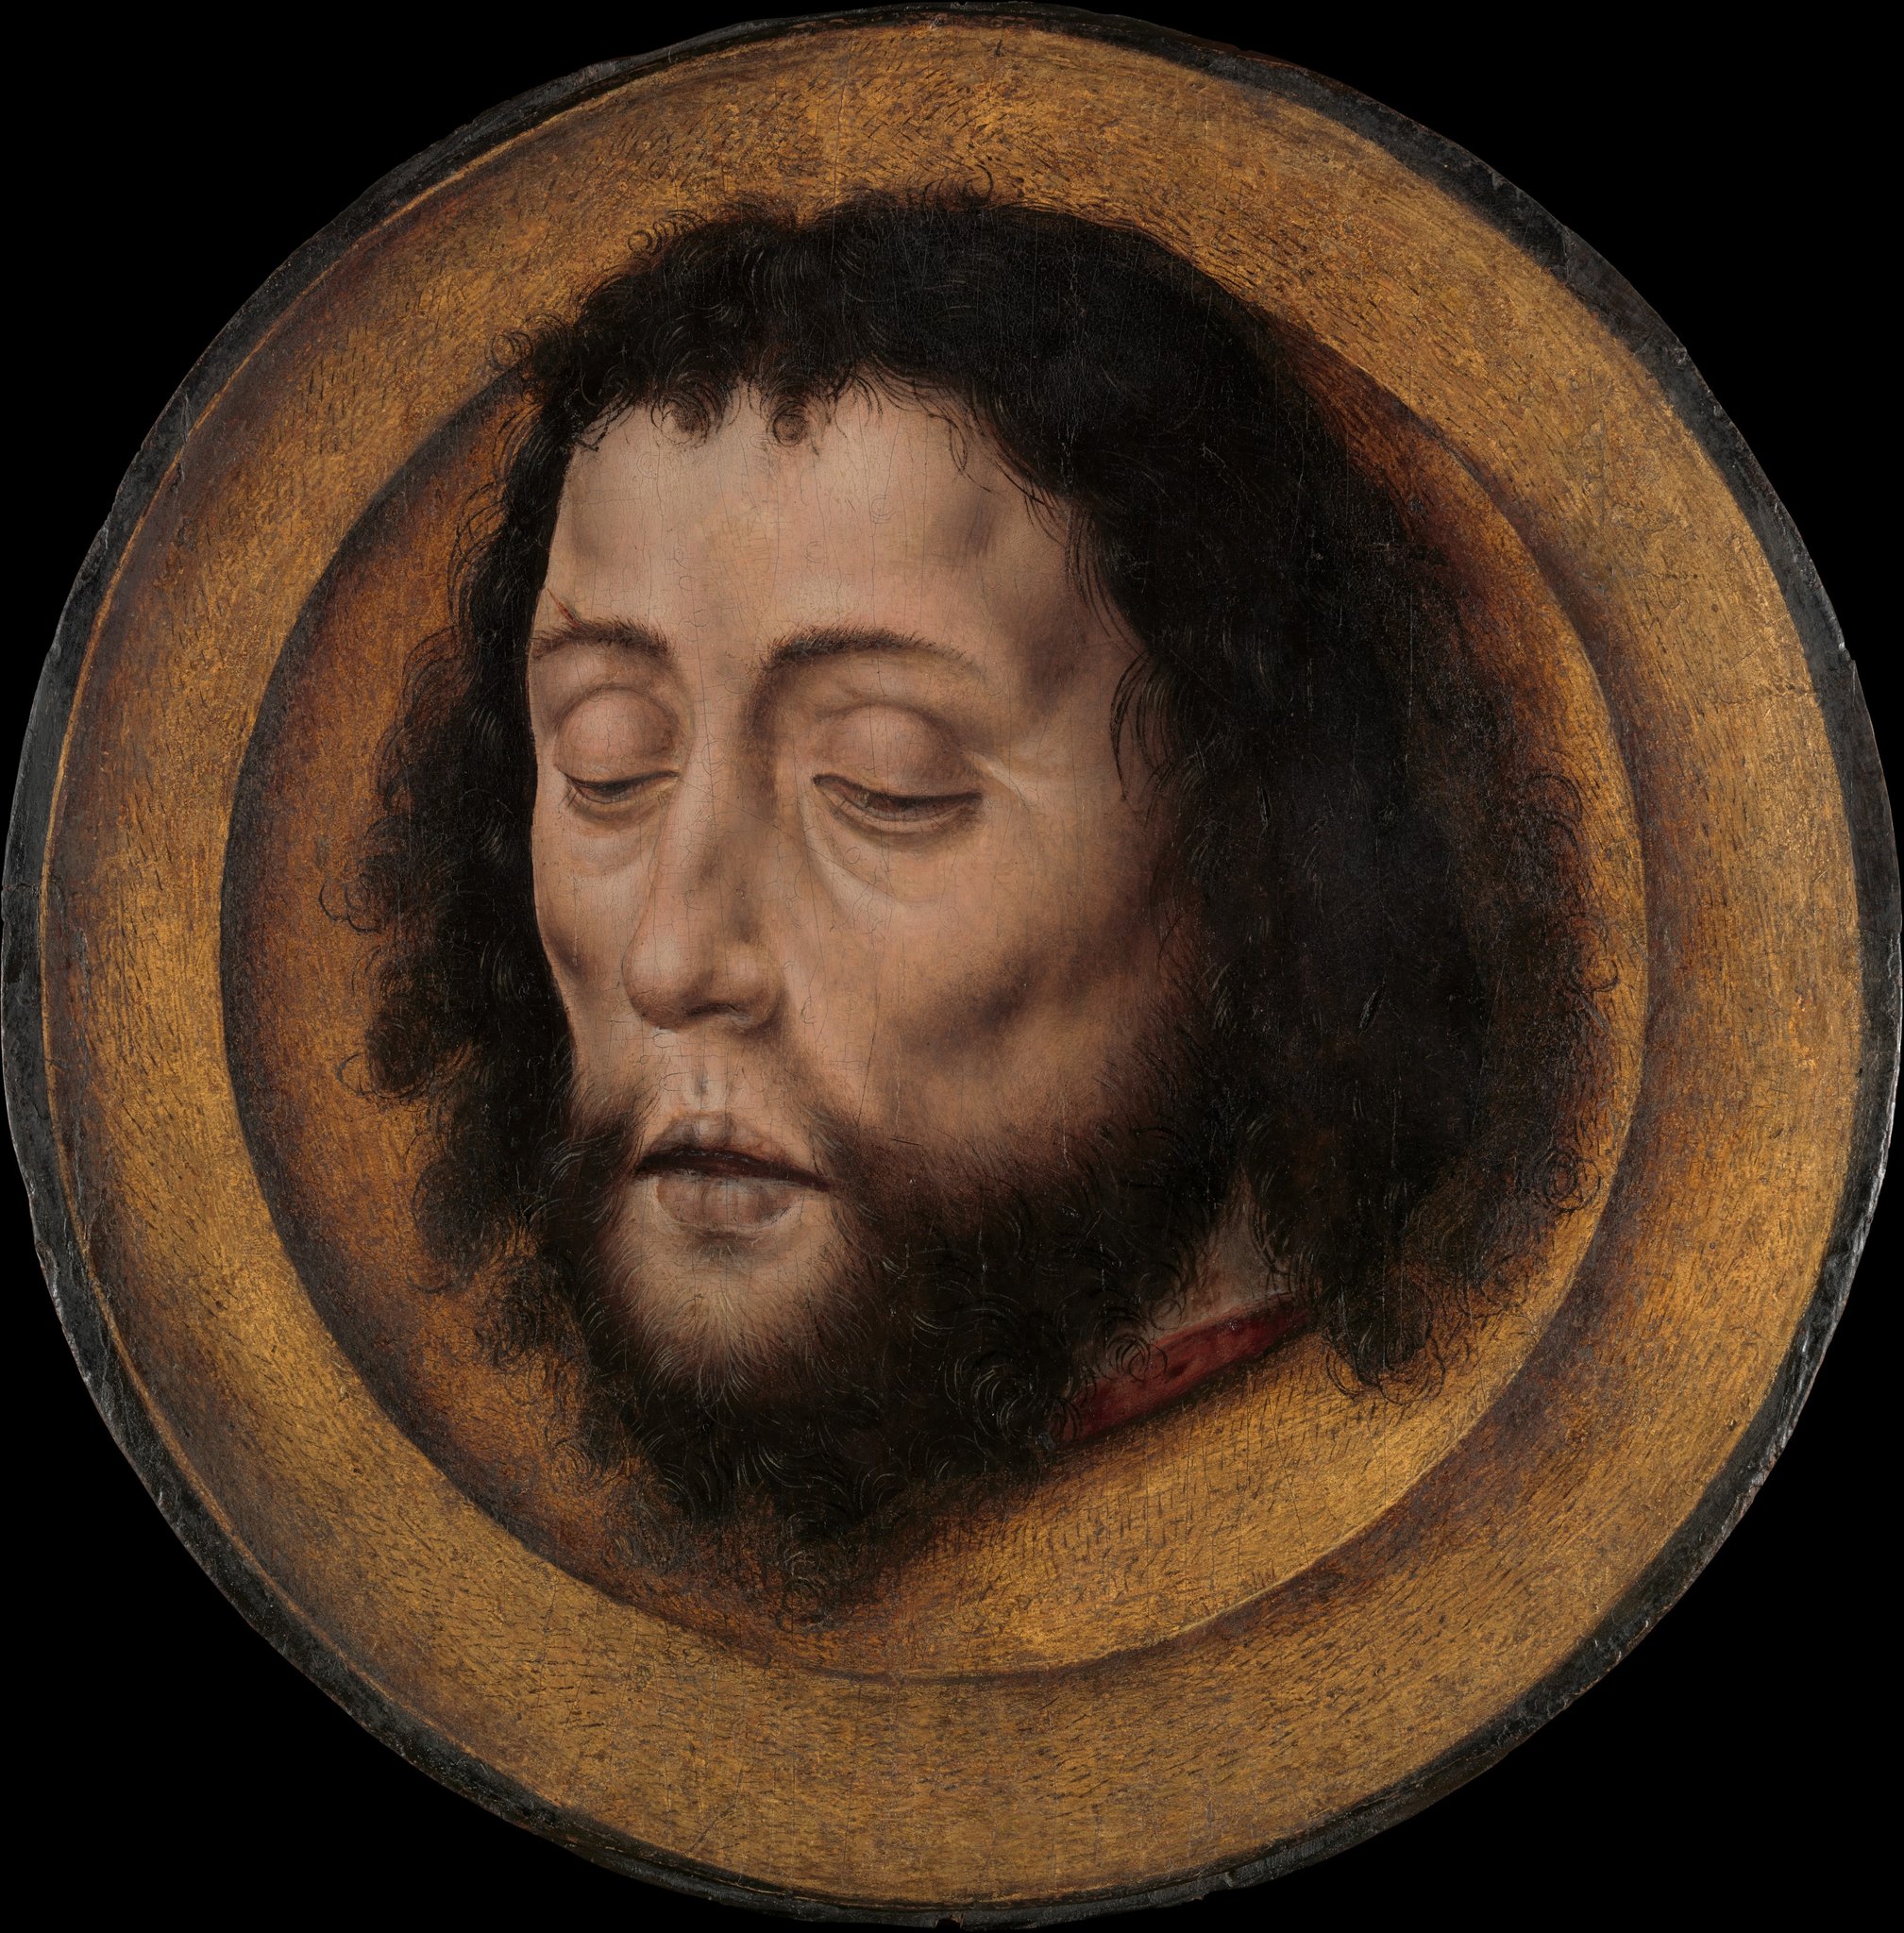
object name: painting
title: Head of Saint John the Baptist on a Charger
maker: aelbert bouts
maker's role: artist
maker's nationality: netherlandish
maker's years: 1451-1549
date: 1500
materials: oil, wood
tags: heads,saint john the baptist